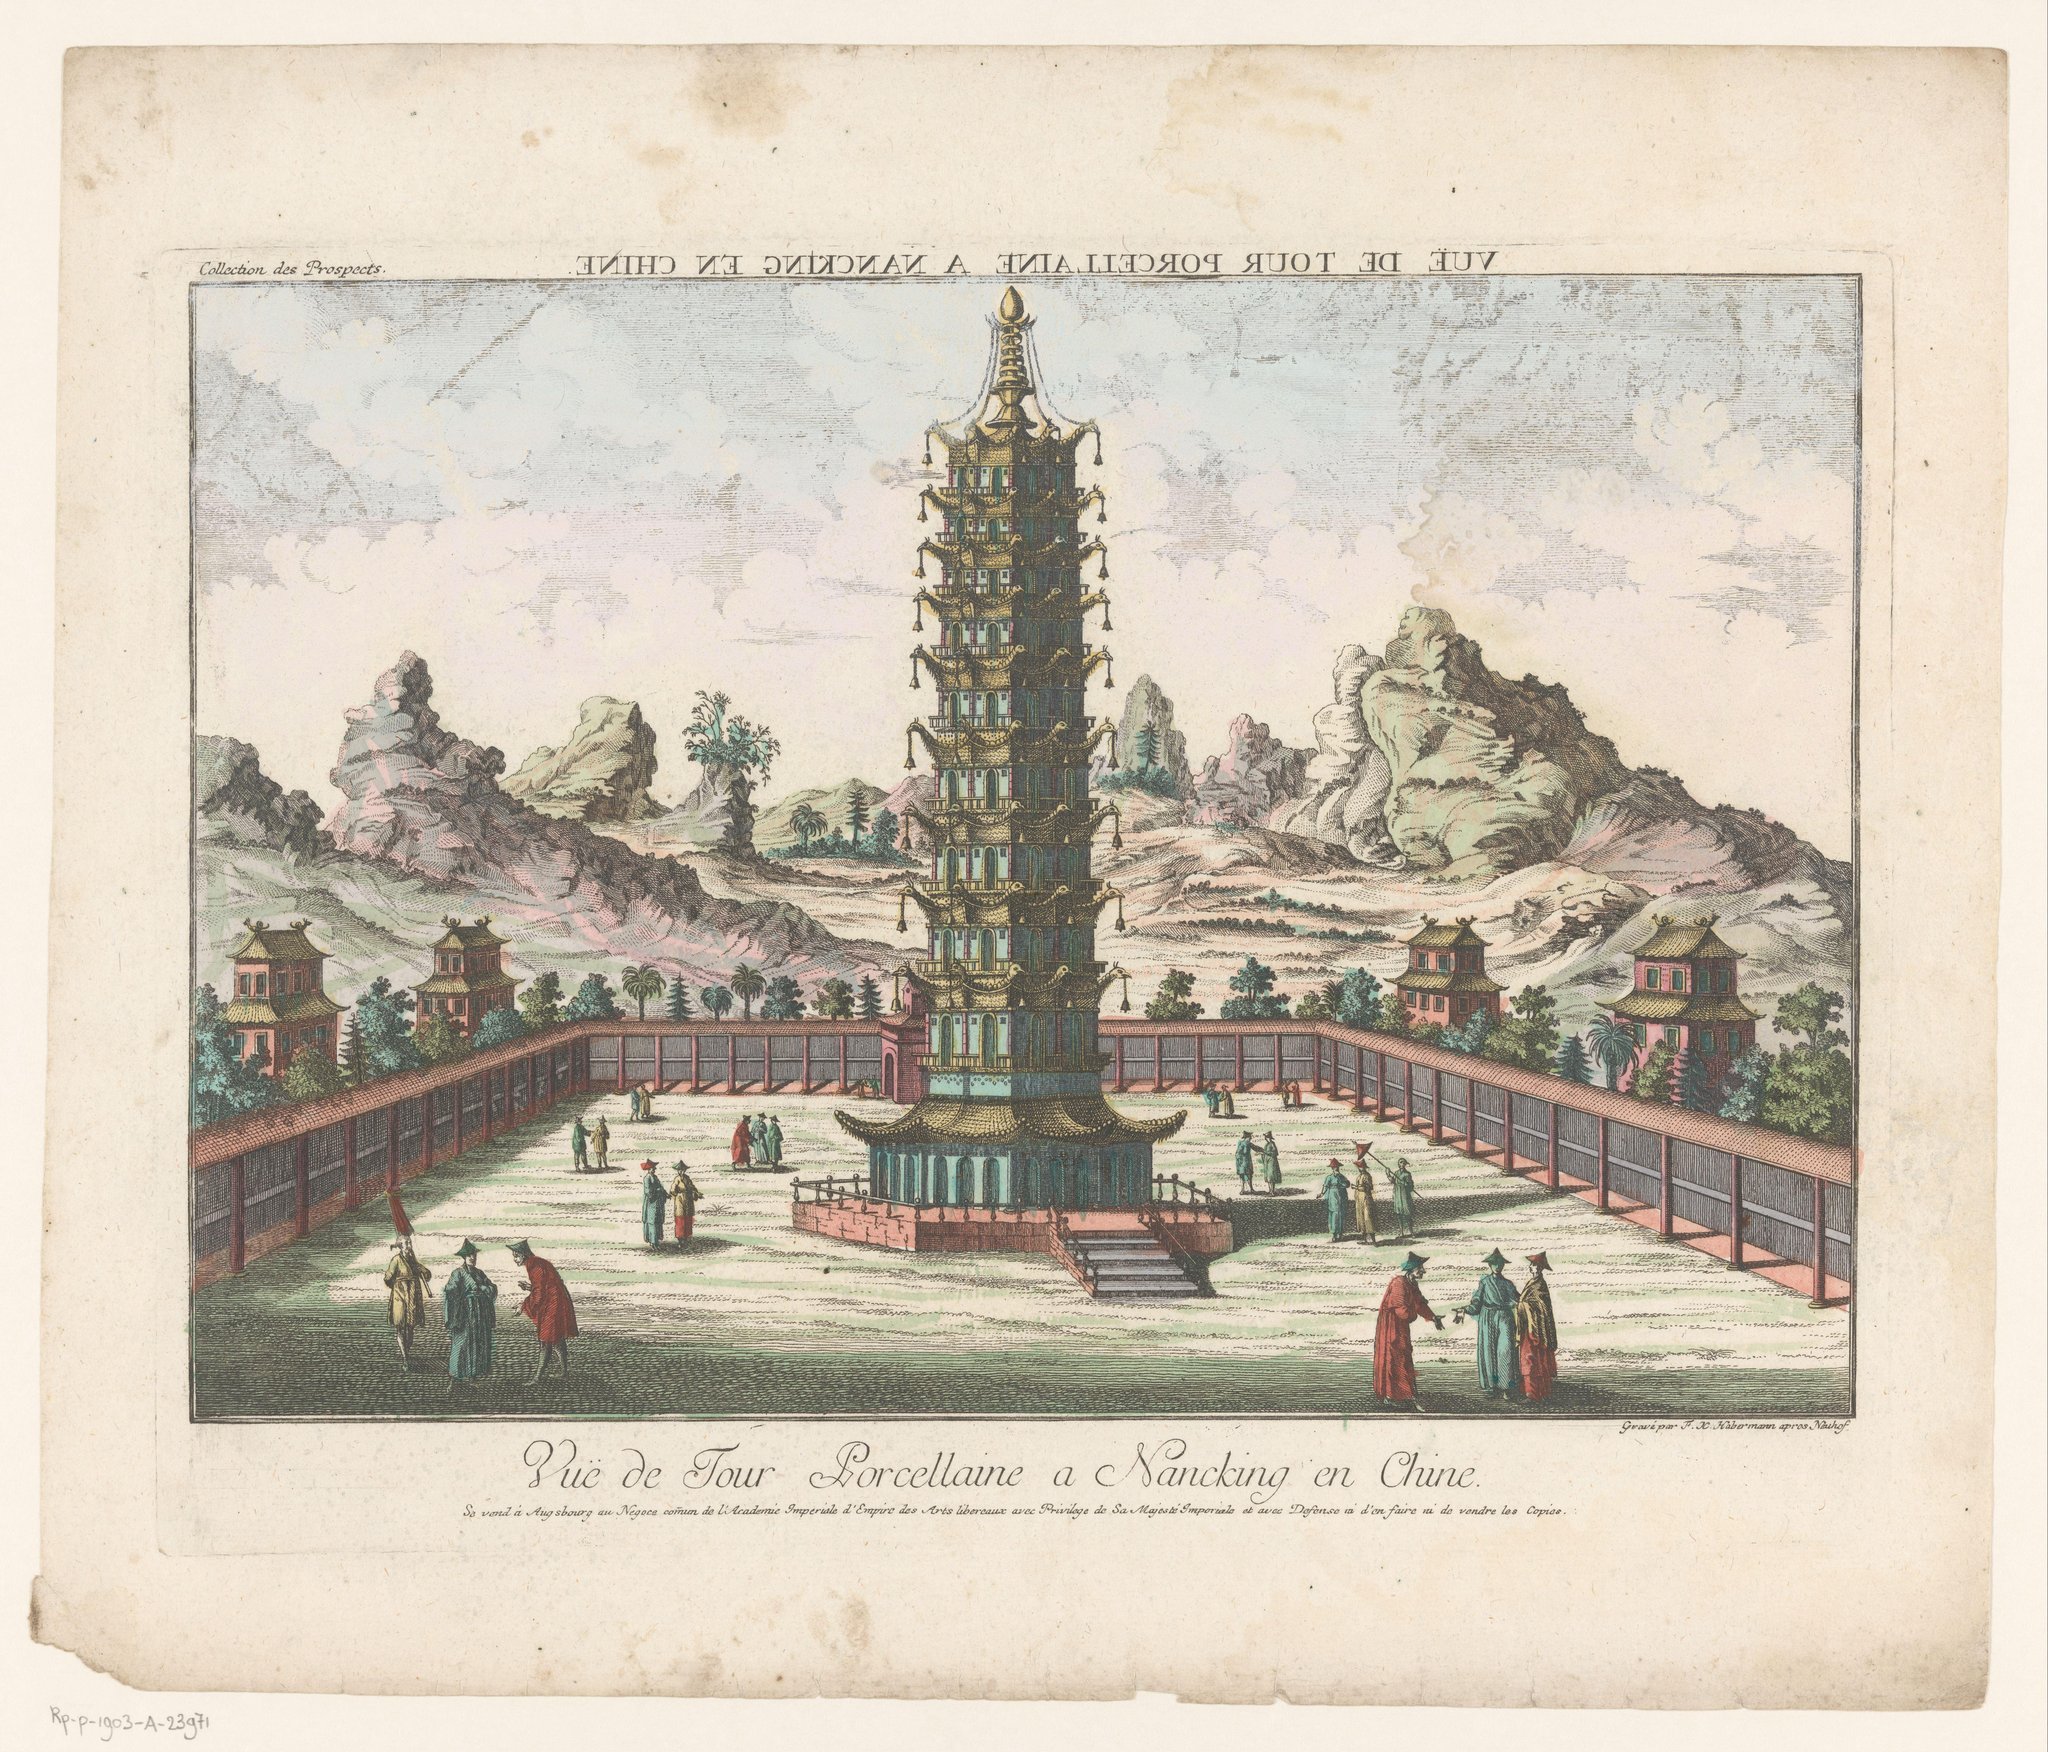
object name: print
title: Gezicht op de porseleintoren van Nanking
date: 1755-1779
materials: paper, watercolor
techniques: brush, etching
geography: augsburg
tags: tower, clock tower ~ monumental adornment, chinese, rock-formations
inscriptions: collector's mark: Lugt 2228